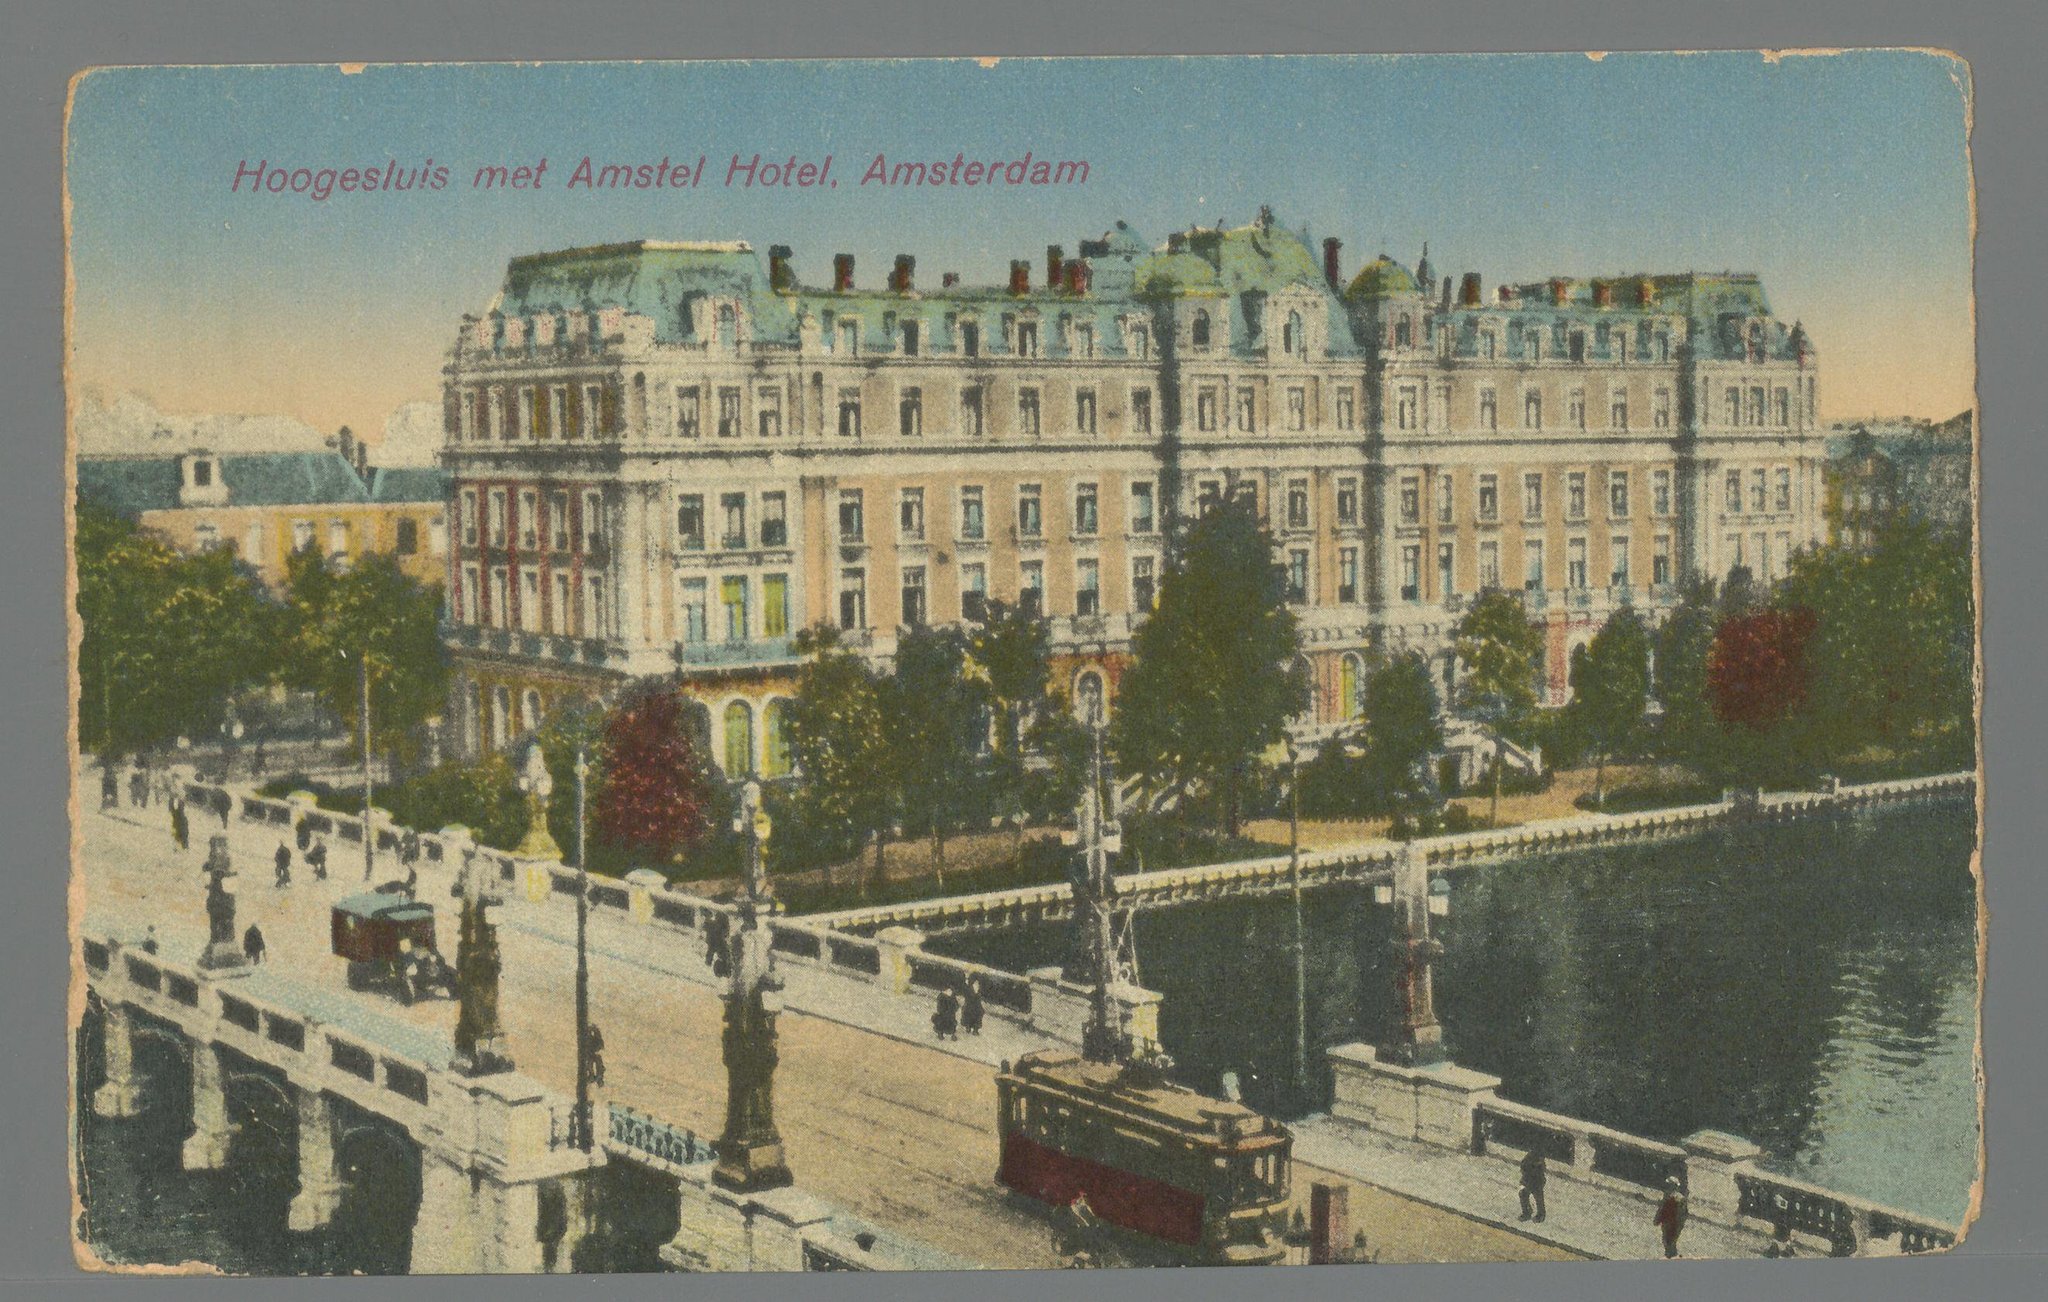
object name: photomechanical print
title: Hoogesluis met Amstel Hotel, Amsterdam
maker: Anonymous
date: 1906-1930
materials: cardboard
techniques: lithograph, hand coloring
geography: amsterdam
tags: city-view, and landscape with man-made constructions, hotel, hostelry, inn, amsterdam